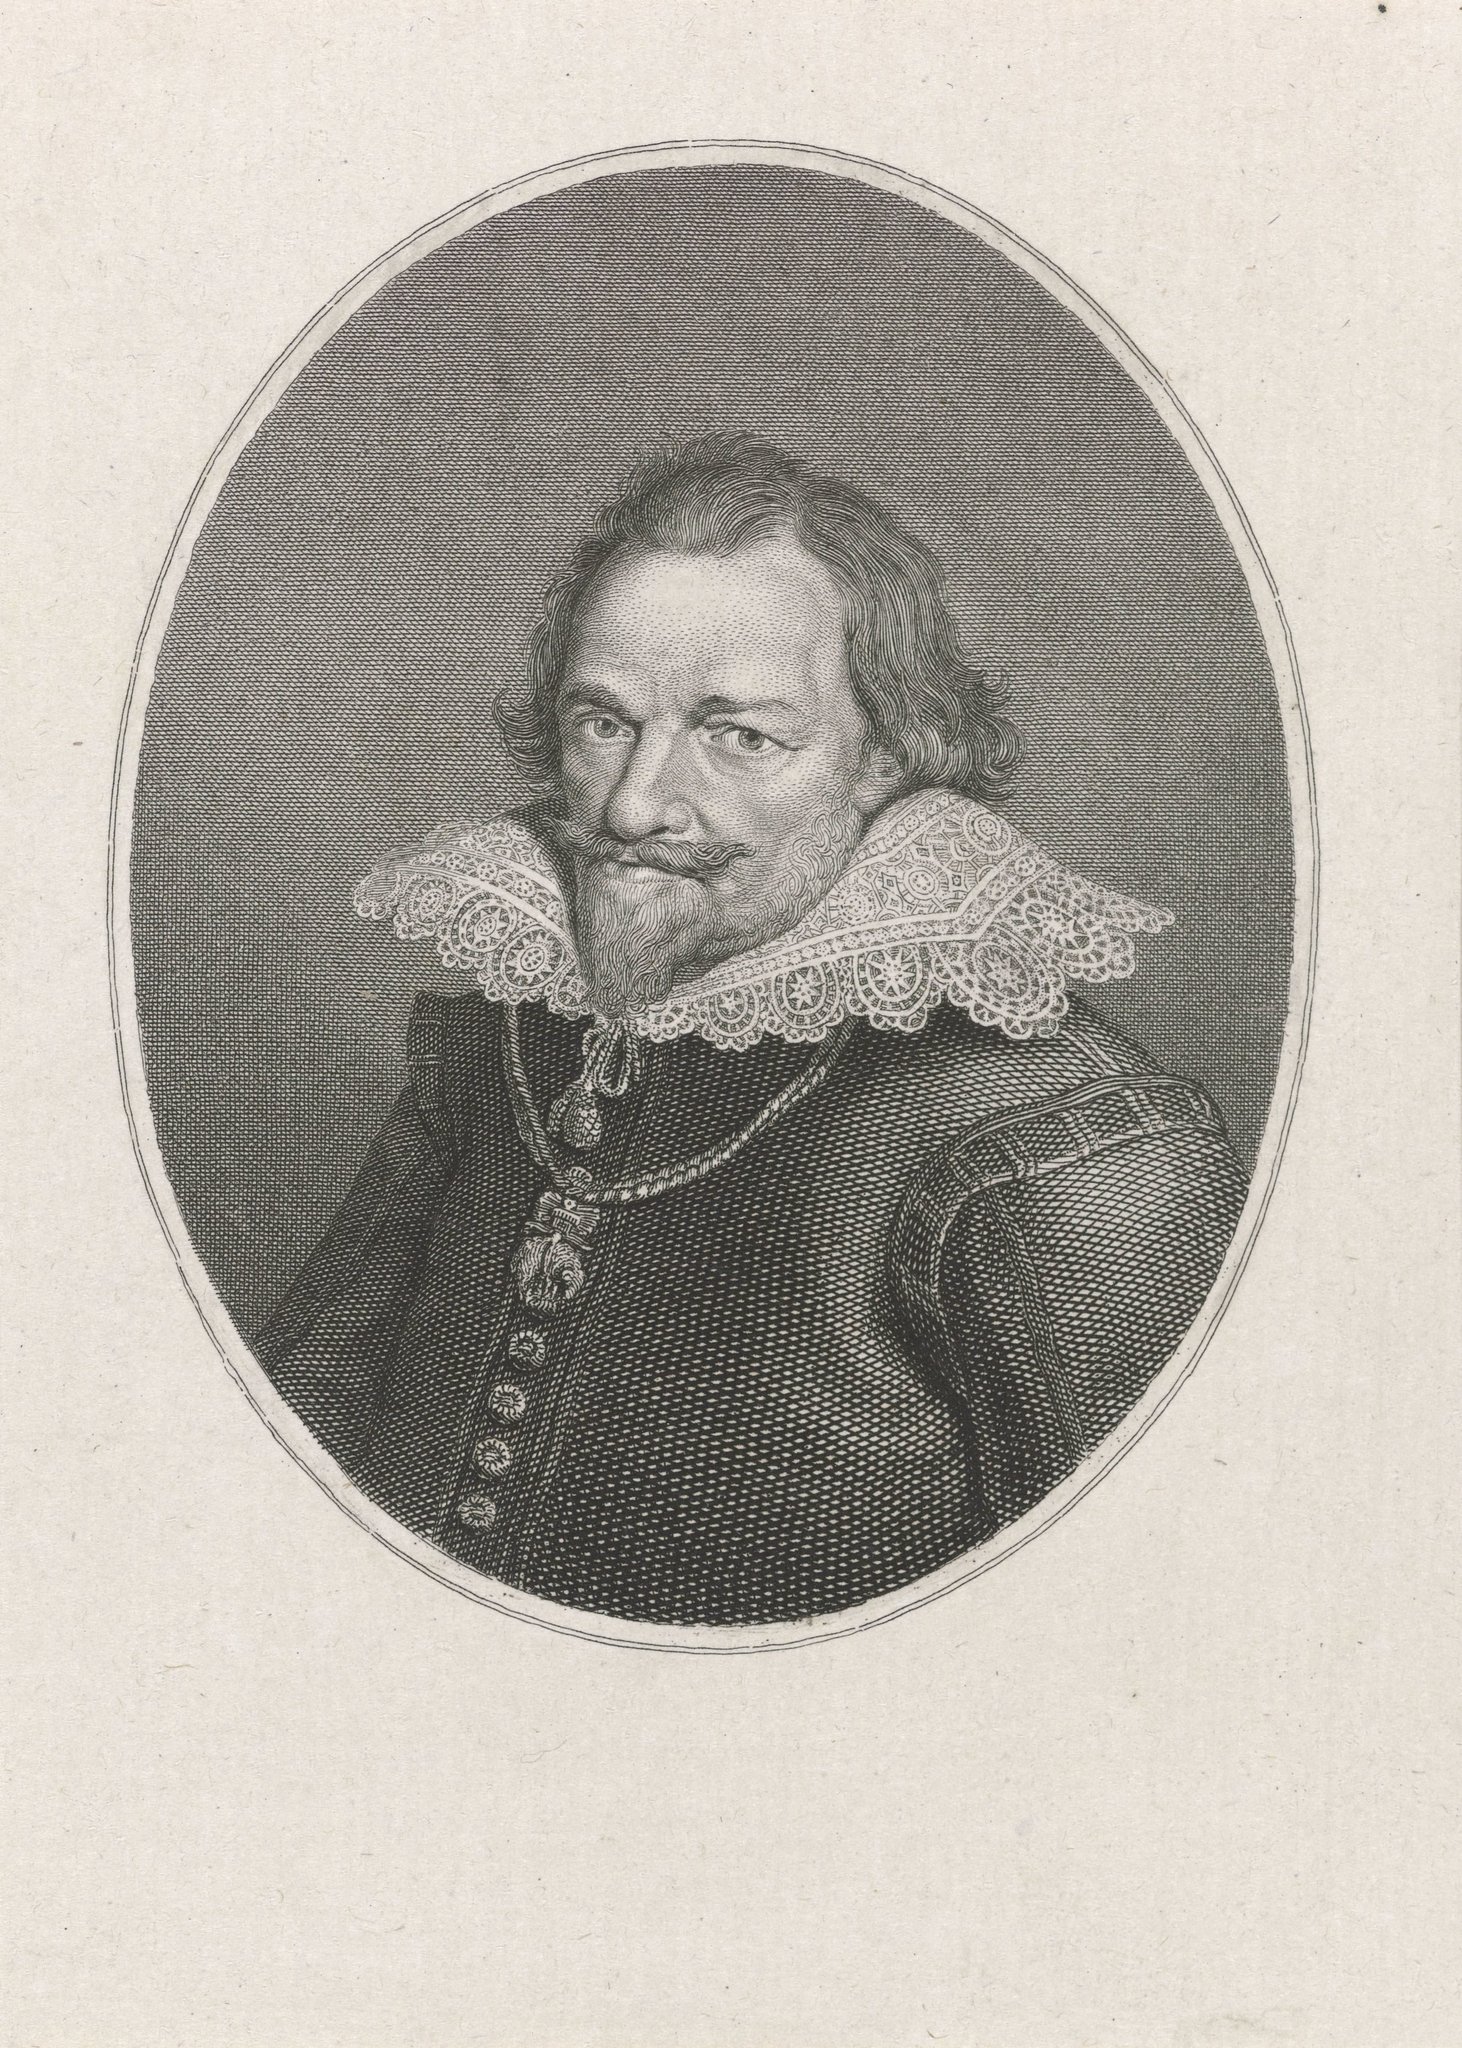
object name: print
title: Portret van Filips Willem, prins van Oranje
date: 1828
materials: paper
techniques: engraving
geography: haarlem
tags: bruges, filips willem (prins van oranje), knighthood order of the golden fleece - insignia of a knighthood order, e.g.: badge, chain (with name of order)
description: De hier vermelde titel verwijst naar de hoogst verkregen titel van de geportretteerde, niet per se naar de titel die de geportretteerde op deze voorstelling draagt.